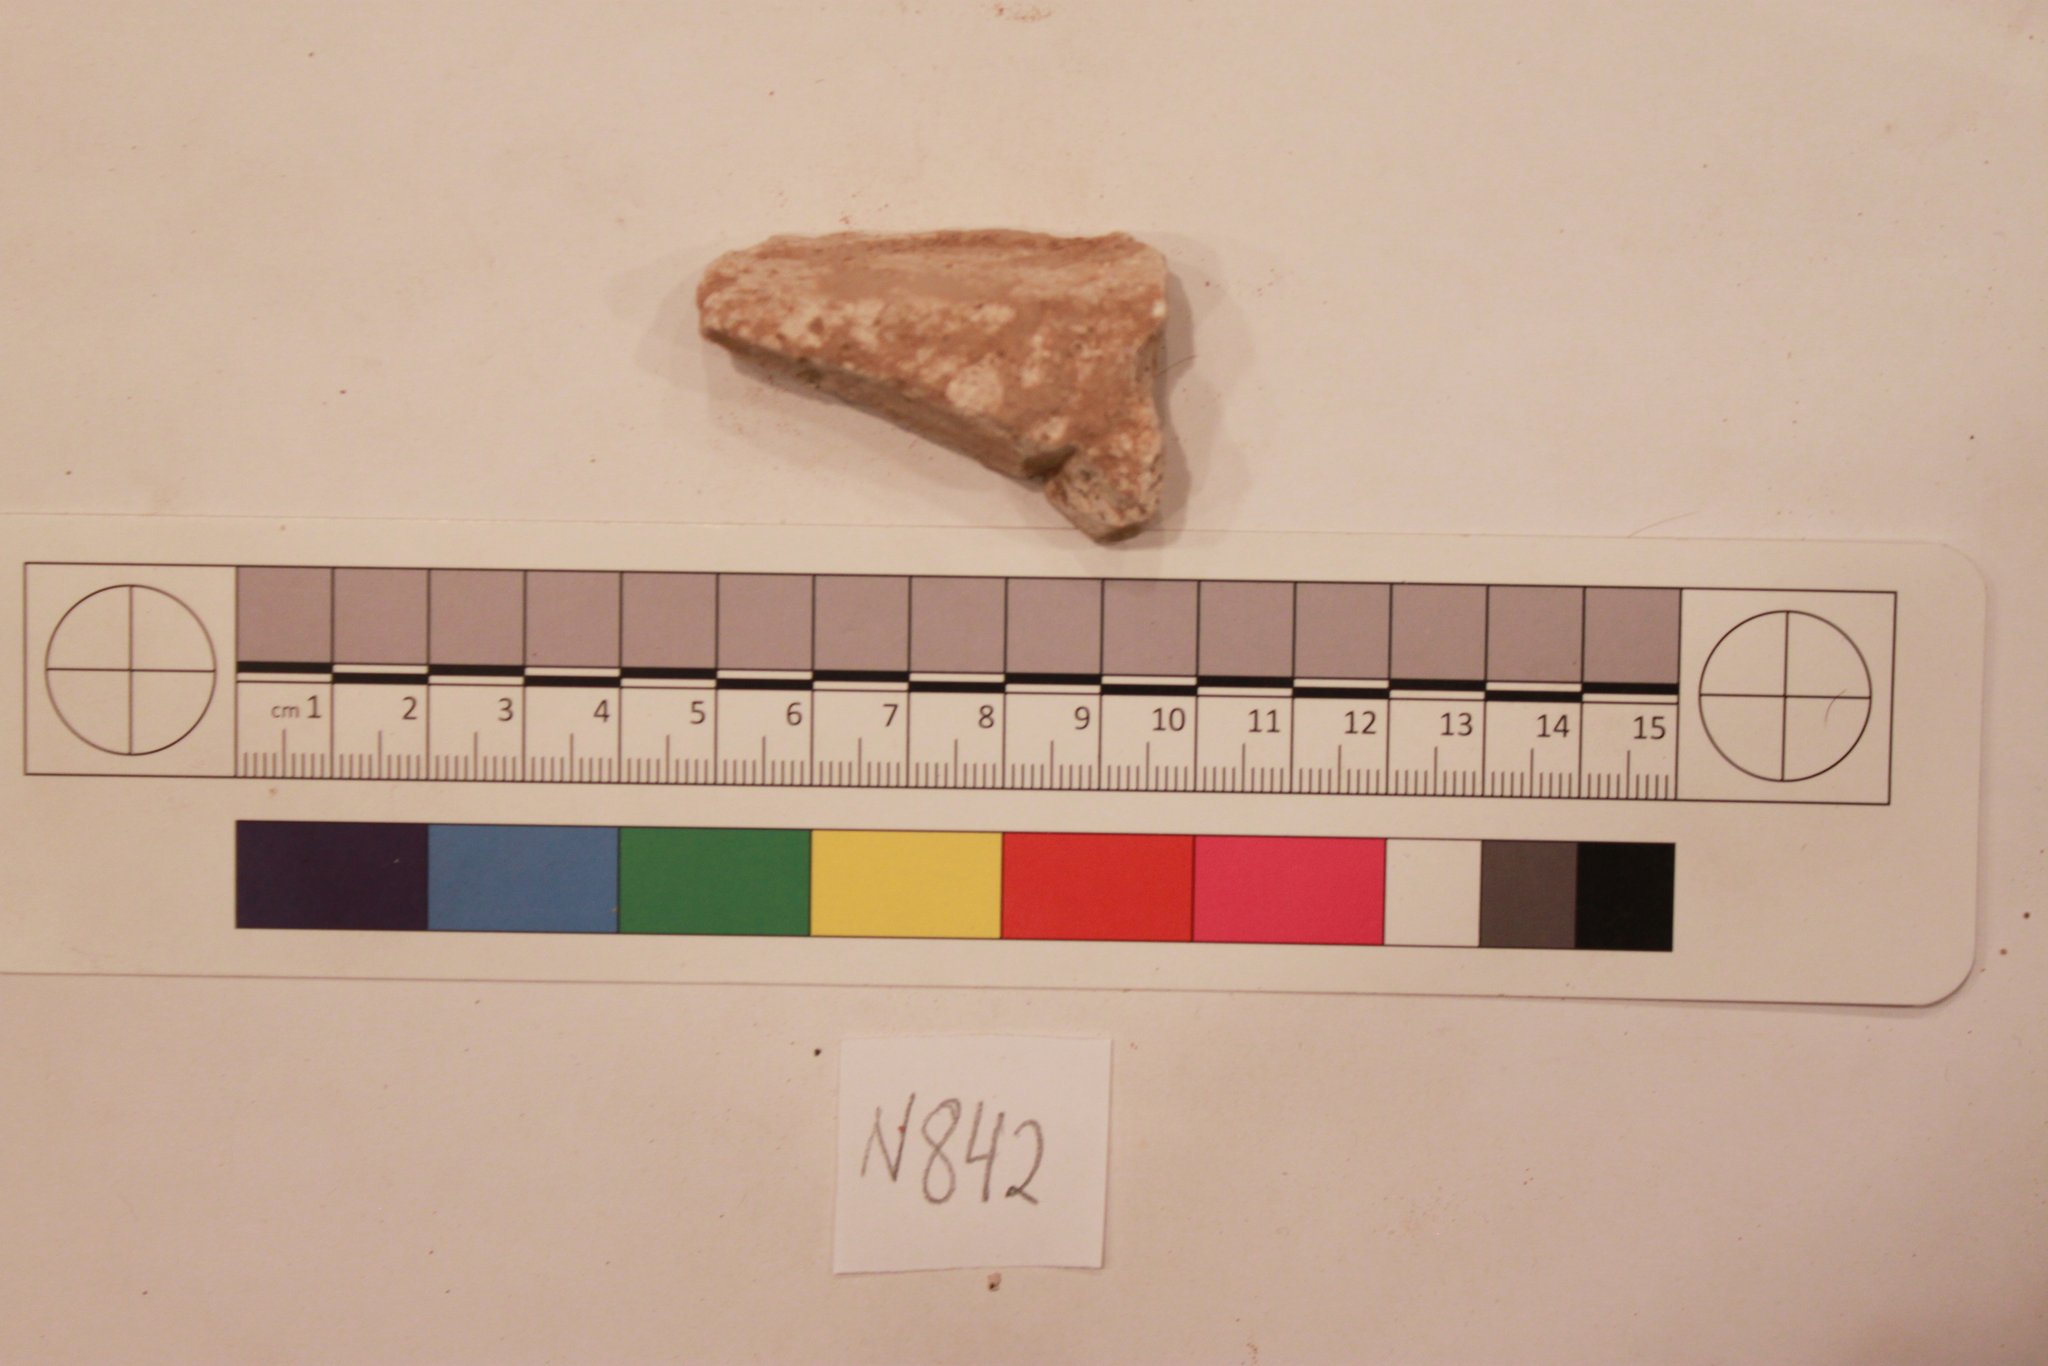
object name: fragment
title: Stucco Fragment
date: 701-1200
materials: plaster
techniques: carving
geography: iran